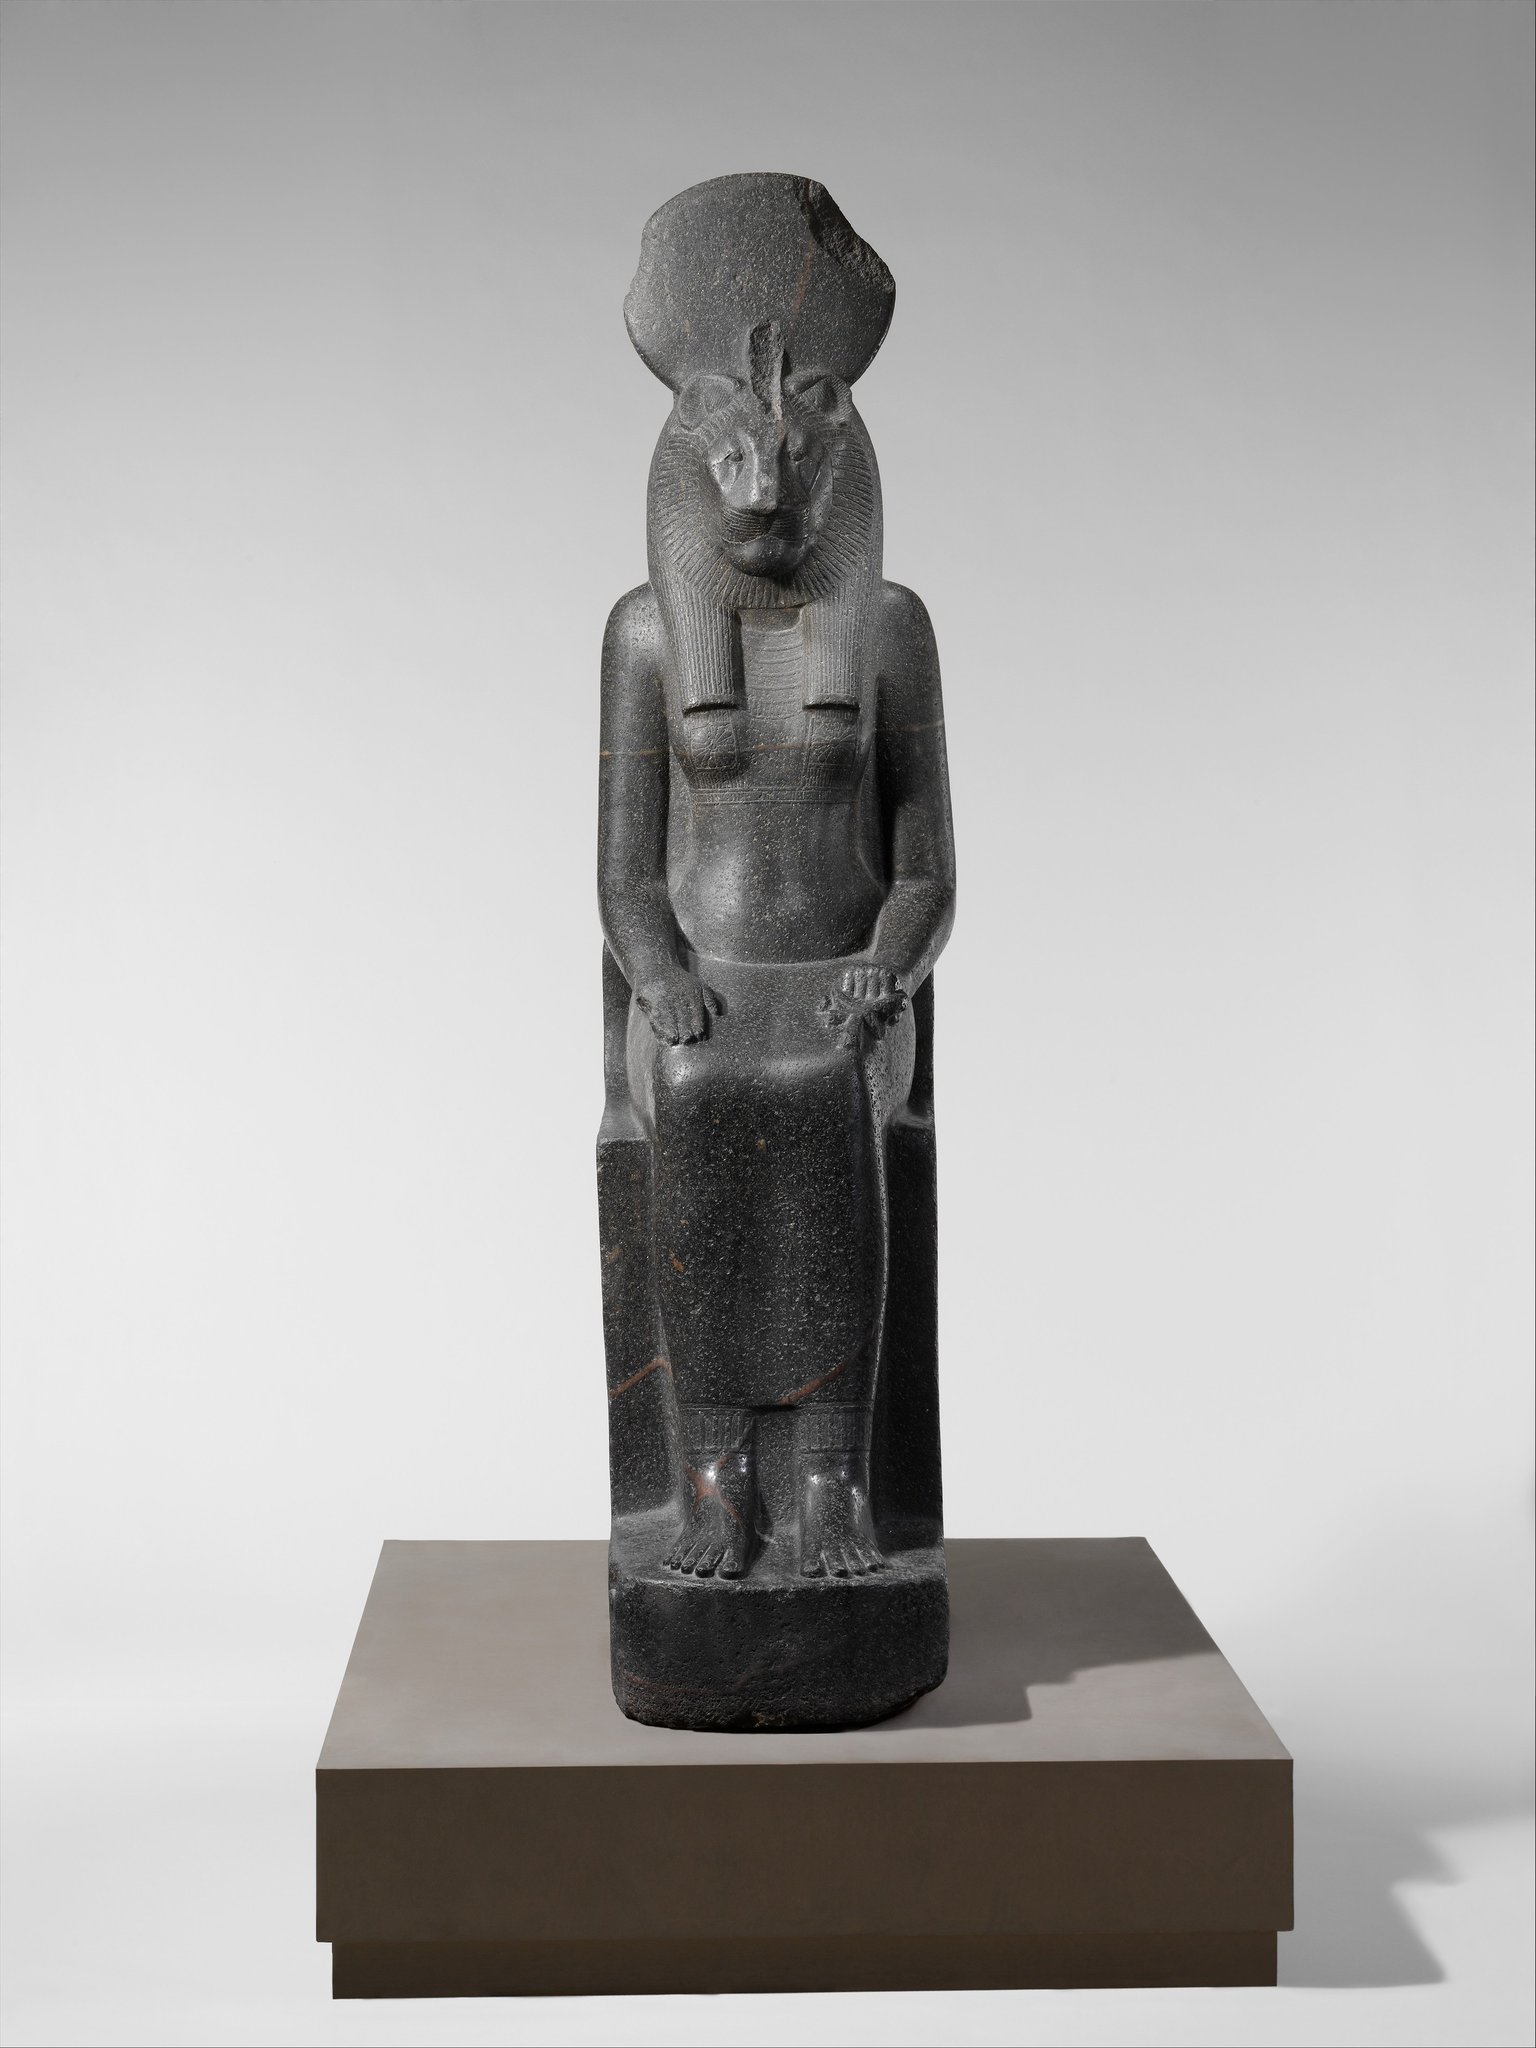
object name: statue, sakhmet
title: Statue of the Goddess Sakhmet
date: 1390-1352 BCE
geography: egypt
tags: goddess